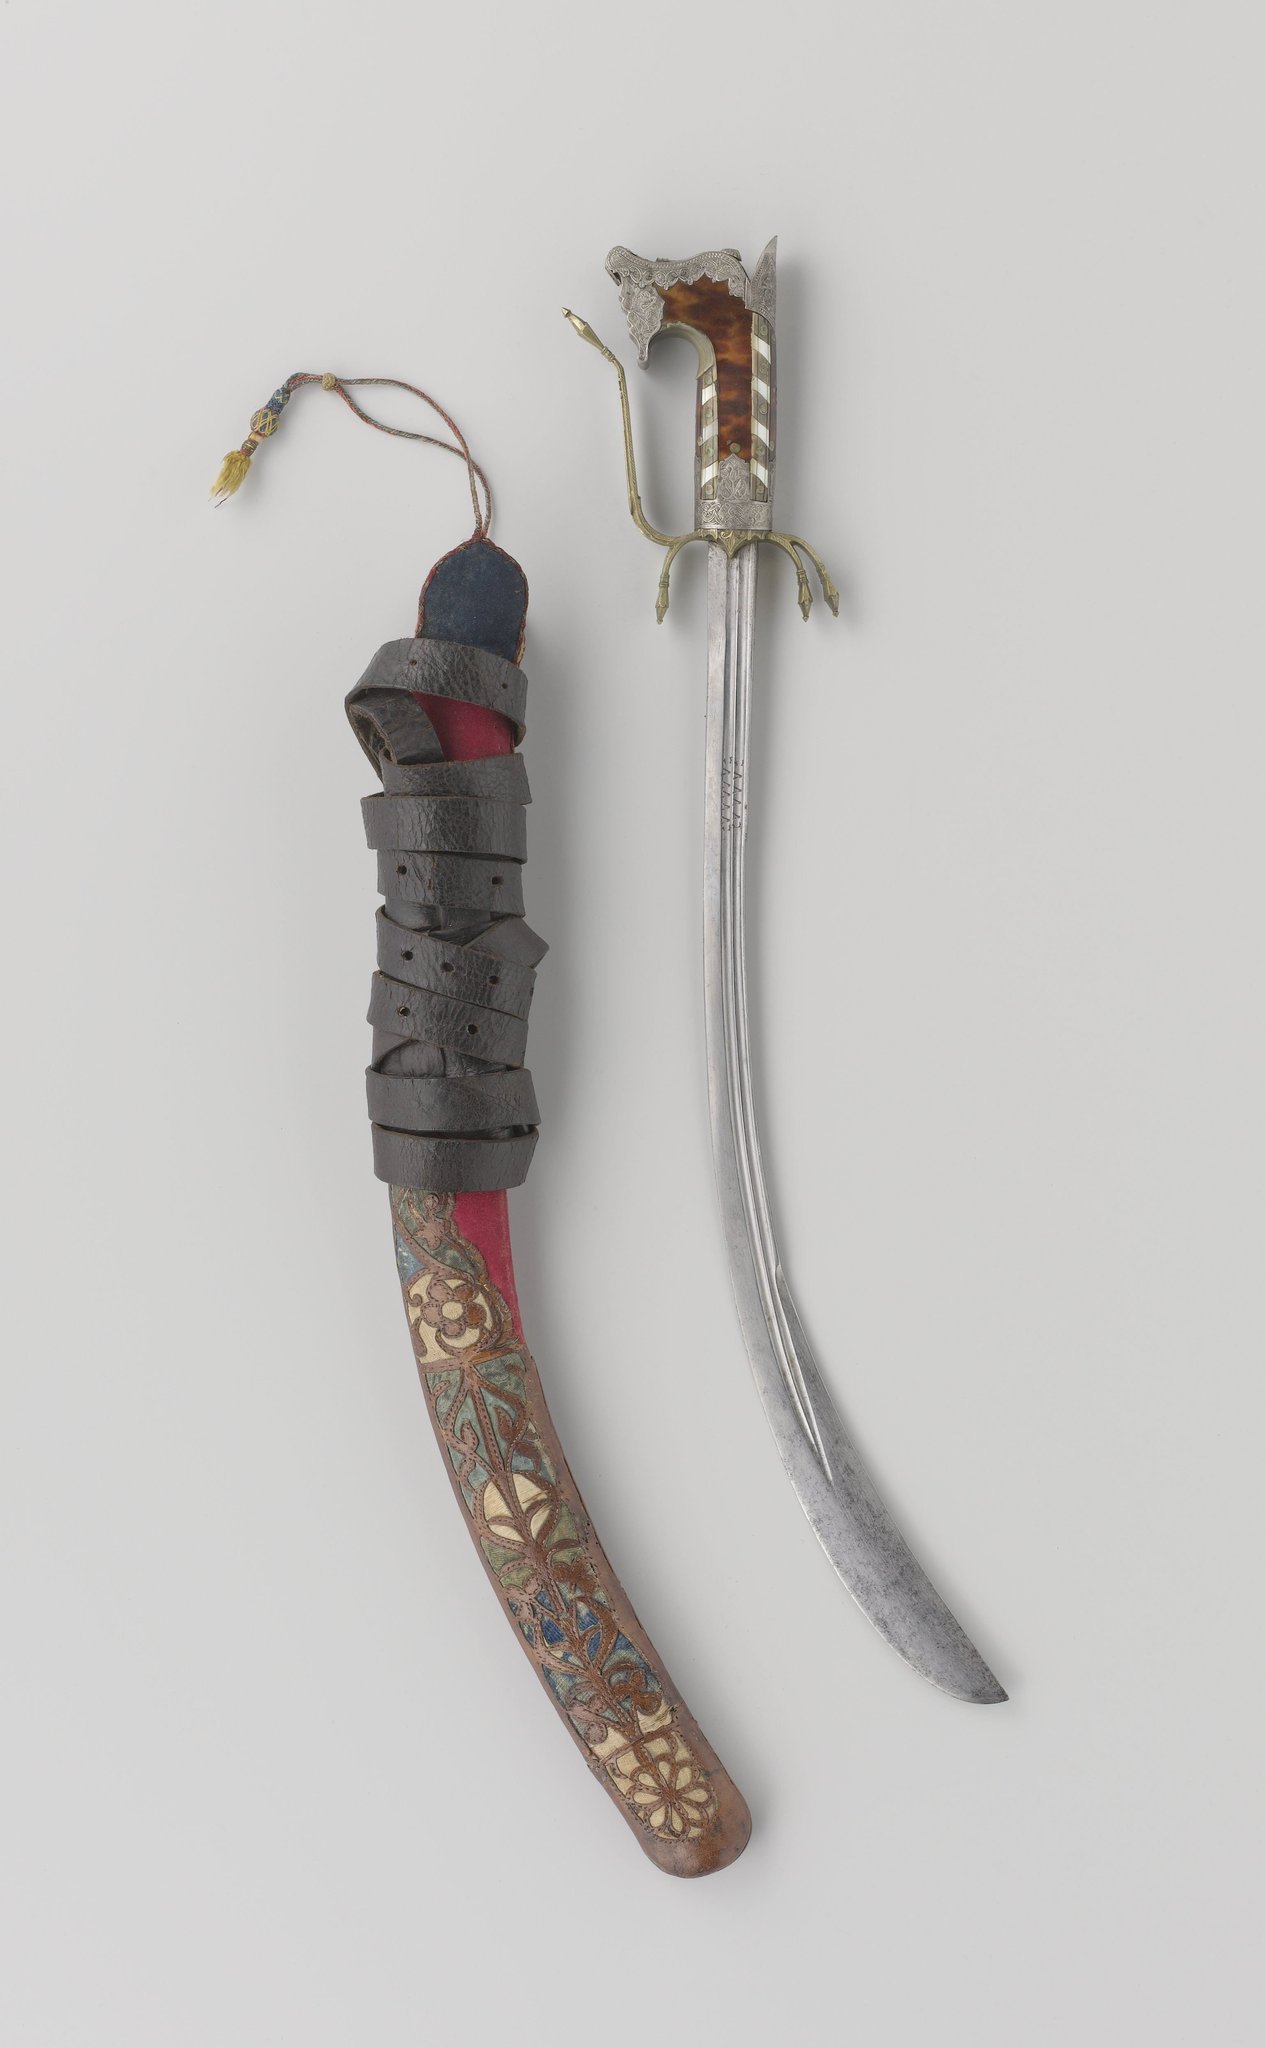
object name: nimcha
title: Sabre (nimcha) of Michiel de Ruyter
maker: Anonymous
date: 1640-1664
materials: textile, copper, iron, leather, mother of pearl, silver, shell, velvet, wood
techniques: engraving, forging, inlay, sawing, sewing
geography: algeria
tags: flushing, michiel adriaenszoon de ruyter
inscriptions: inscription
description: According to tradition, Michiel de Ruyter captured this nimcha (sabre) in 1655 from an Algerian corsair. Between 1644 and 1664 the admiral repeatedly went to the Mediterranean. His missions there included punitive expeditions against the cities of Algiers, Tunis and Tripoli, whose corsairs were menacing Dutch merchant ships.